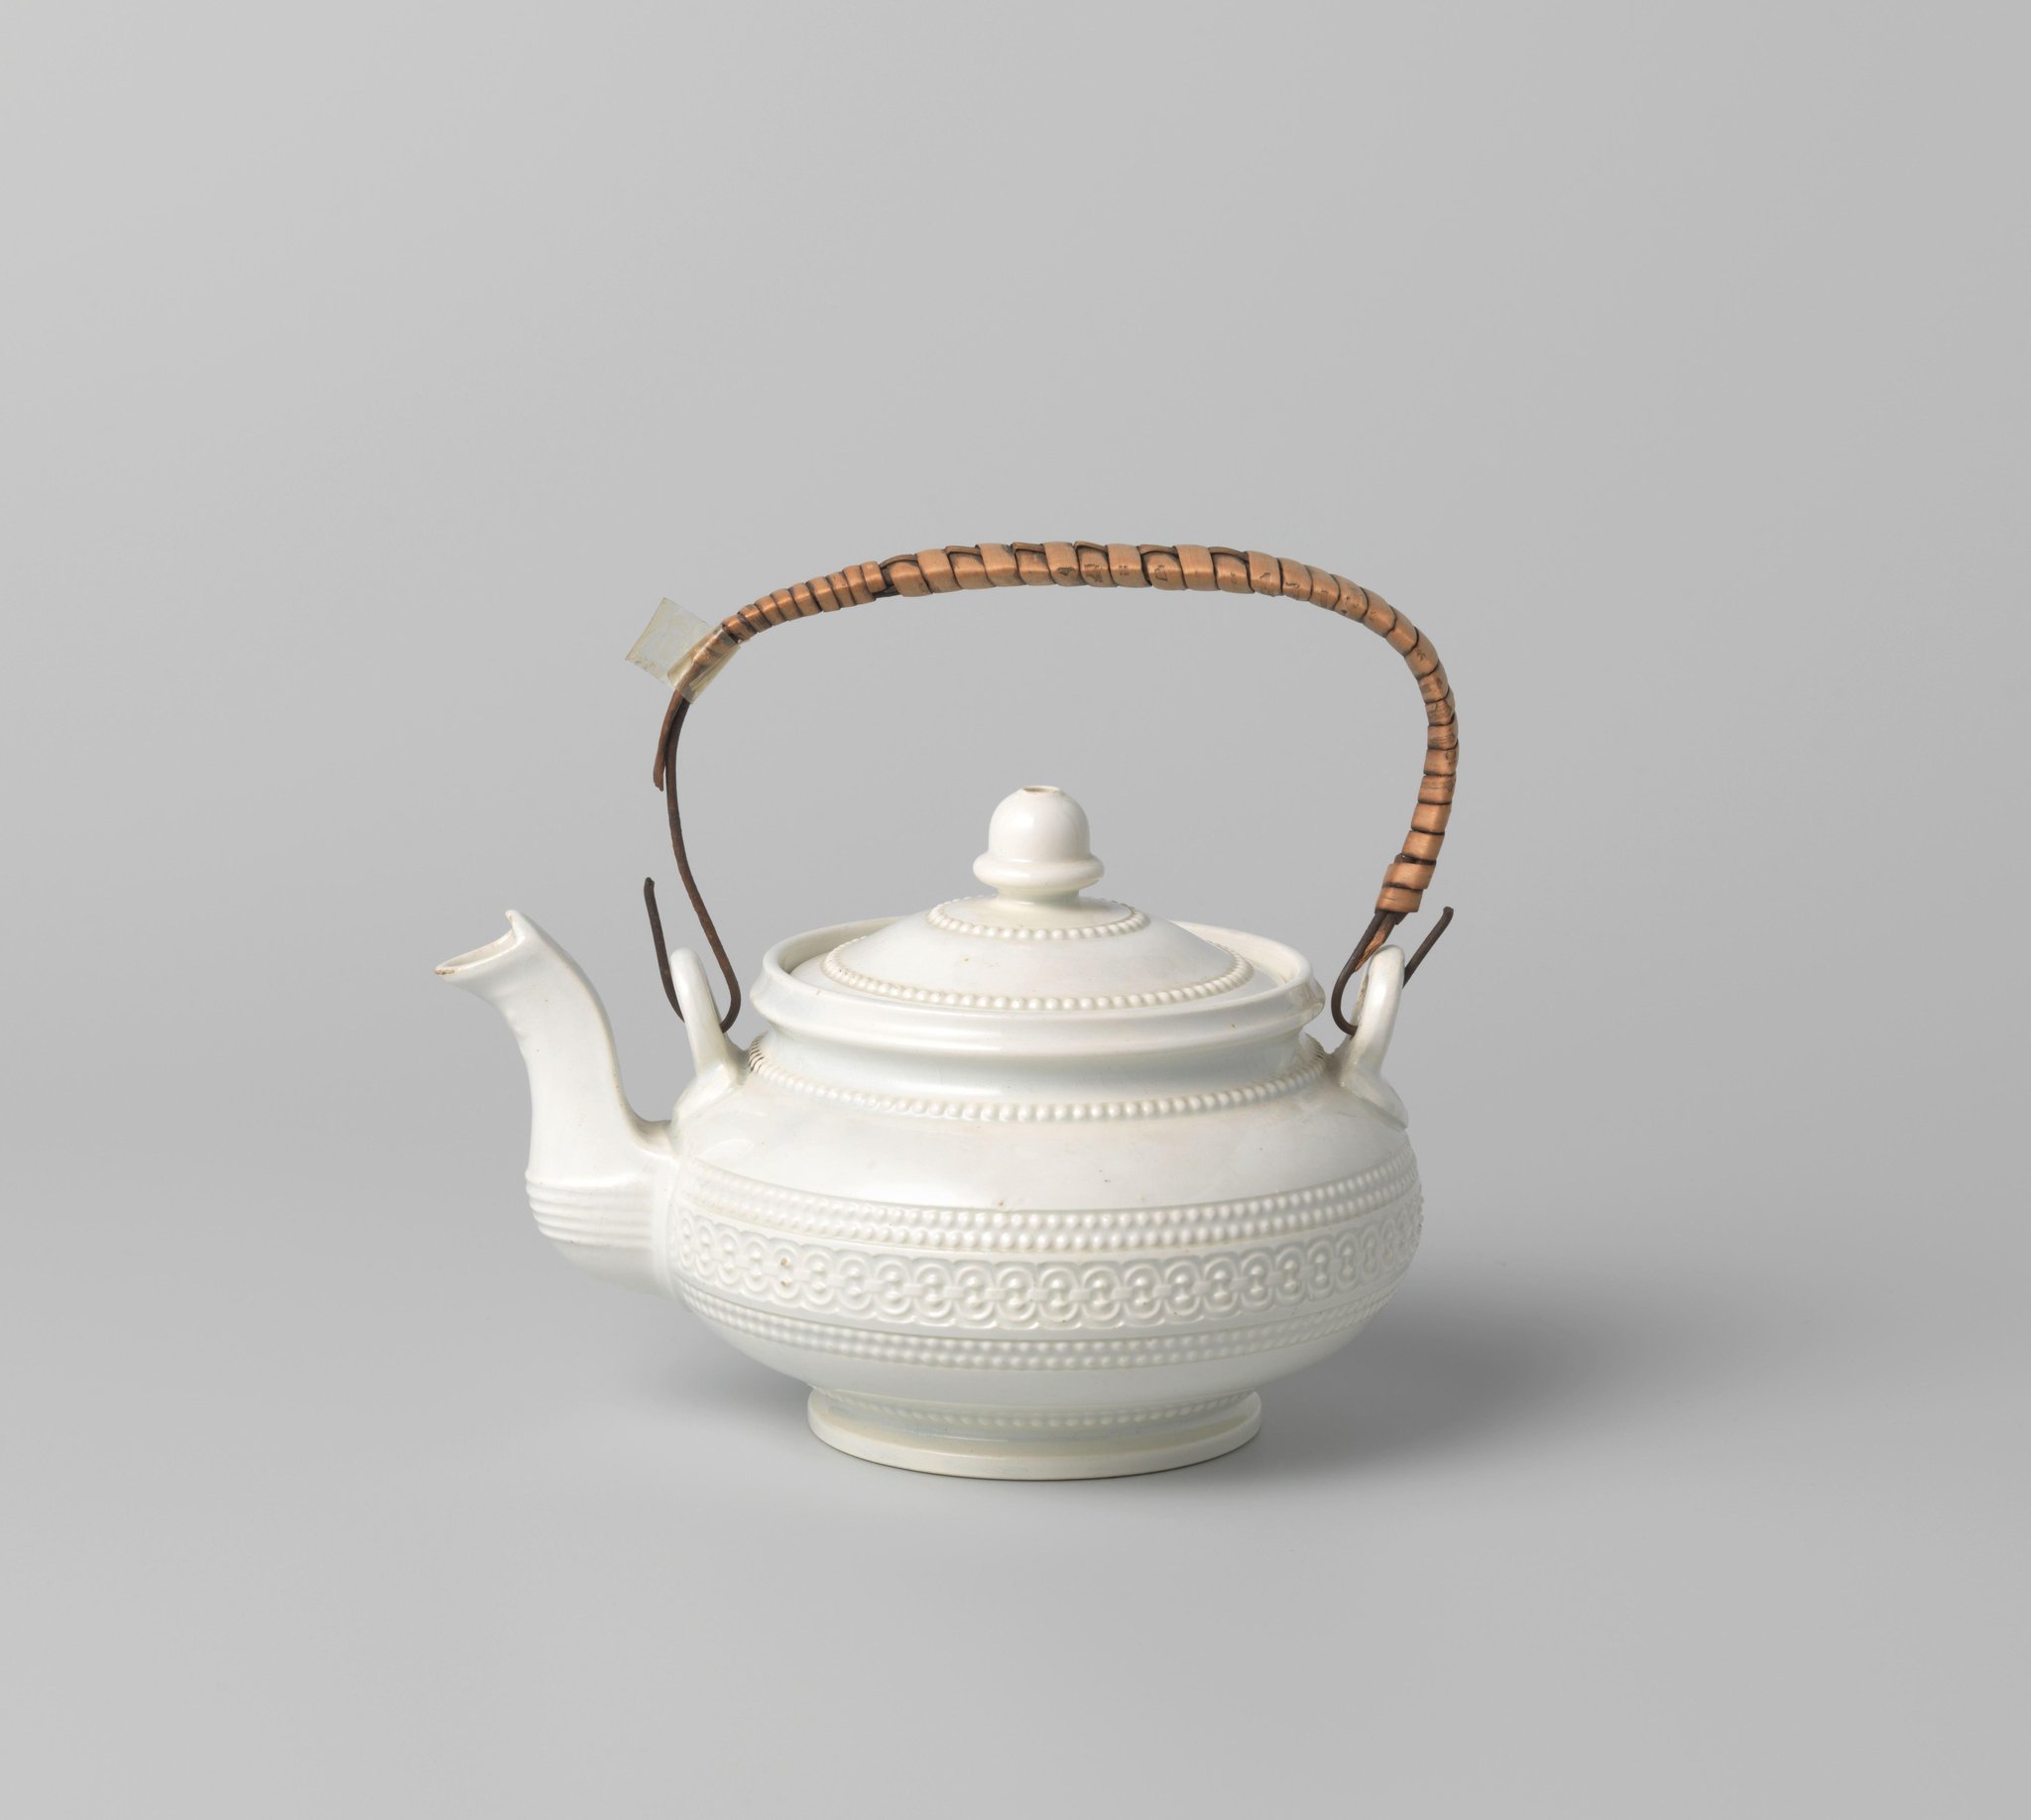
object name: kettle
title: Deksel, crèmekleurig, met kettingrand in reliëf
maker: petrus regout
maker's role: plateelbakker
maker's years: 1801-1879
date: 1860-1890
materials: creamware, metal thread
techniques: vitrification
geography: maastricht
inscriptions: check stamp: ‘P. REGOUT // 36 // MAASTRICHT’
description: Deksel van aardewerk, crèmekleurig. Het gewelfde deksel met twee parelranden. Het deksel wordt bekroond door een eikelvormige knop met luchtgat.